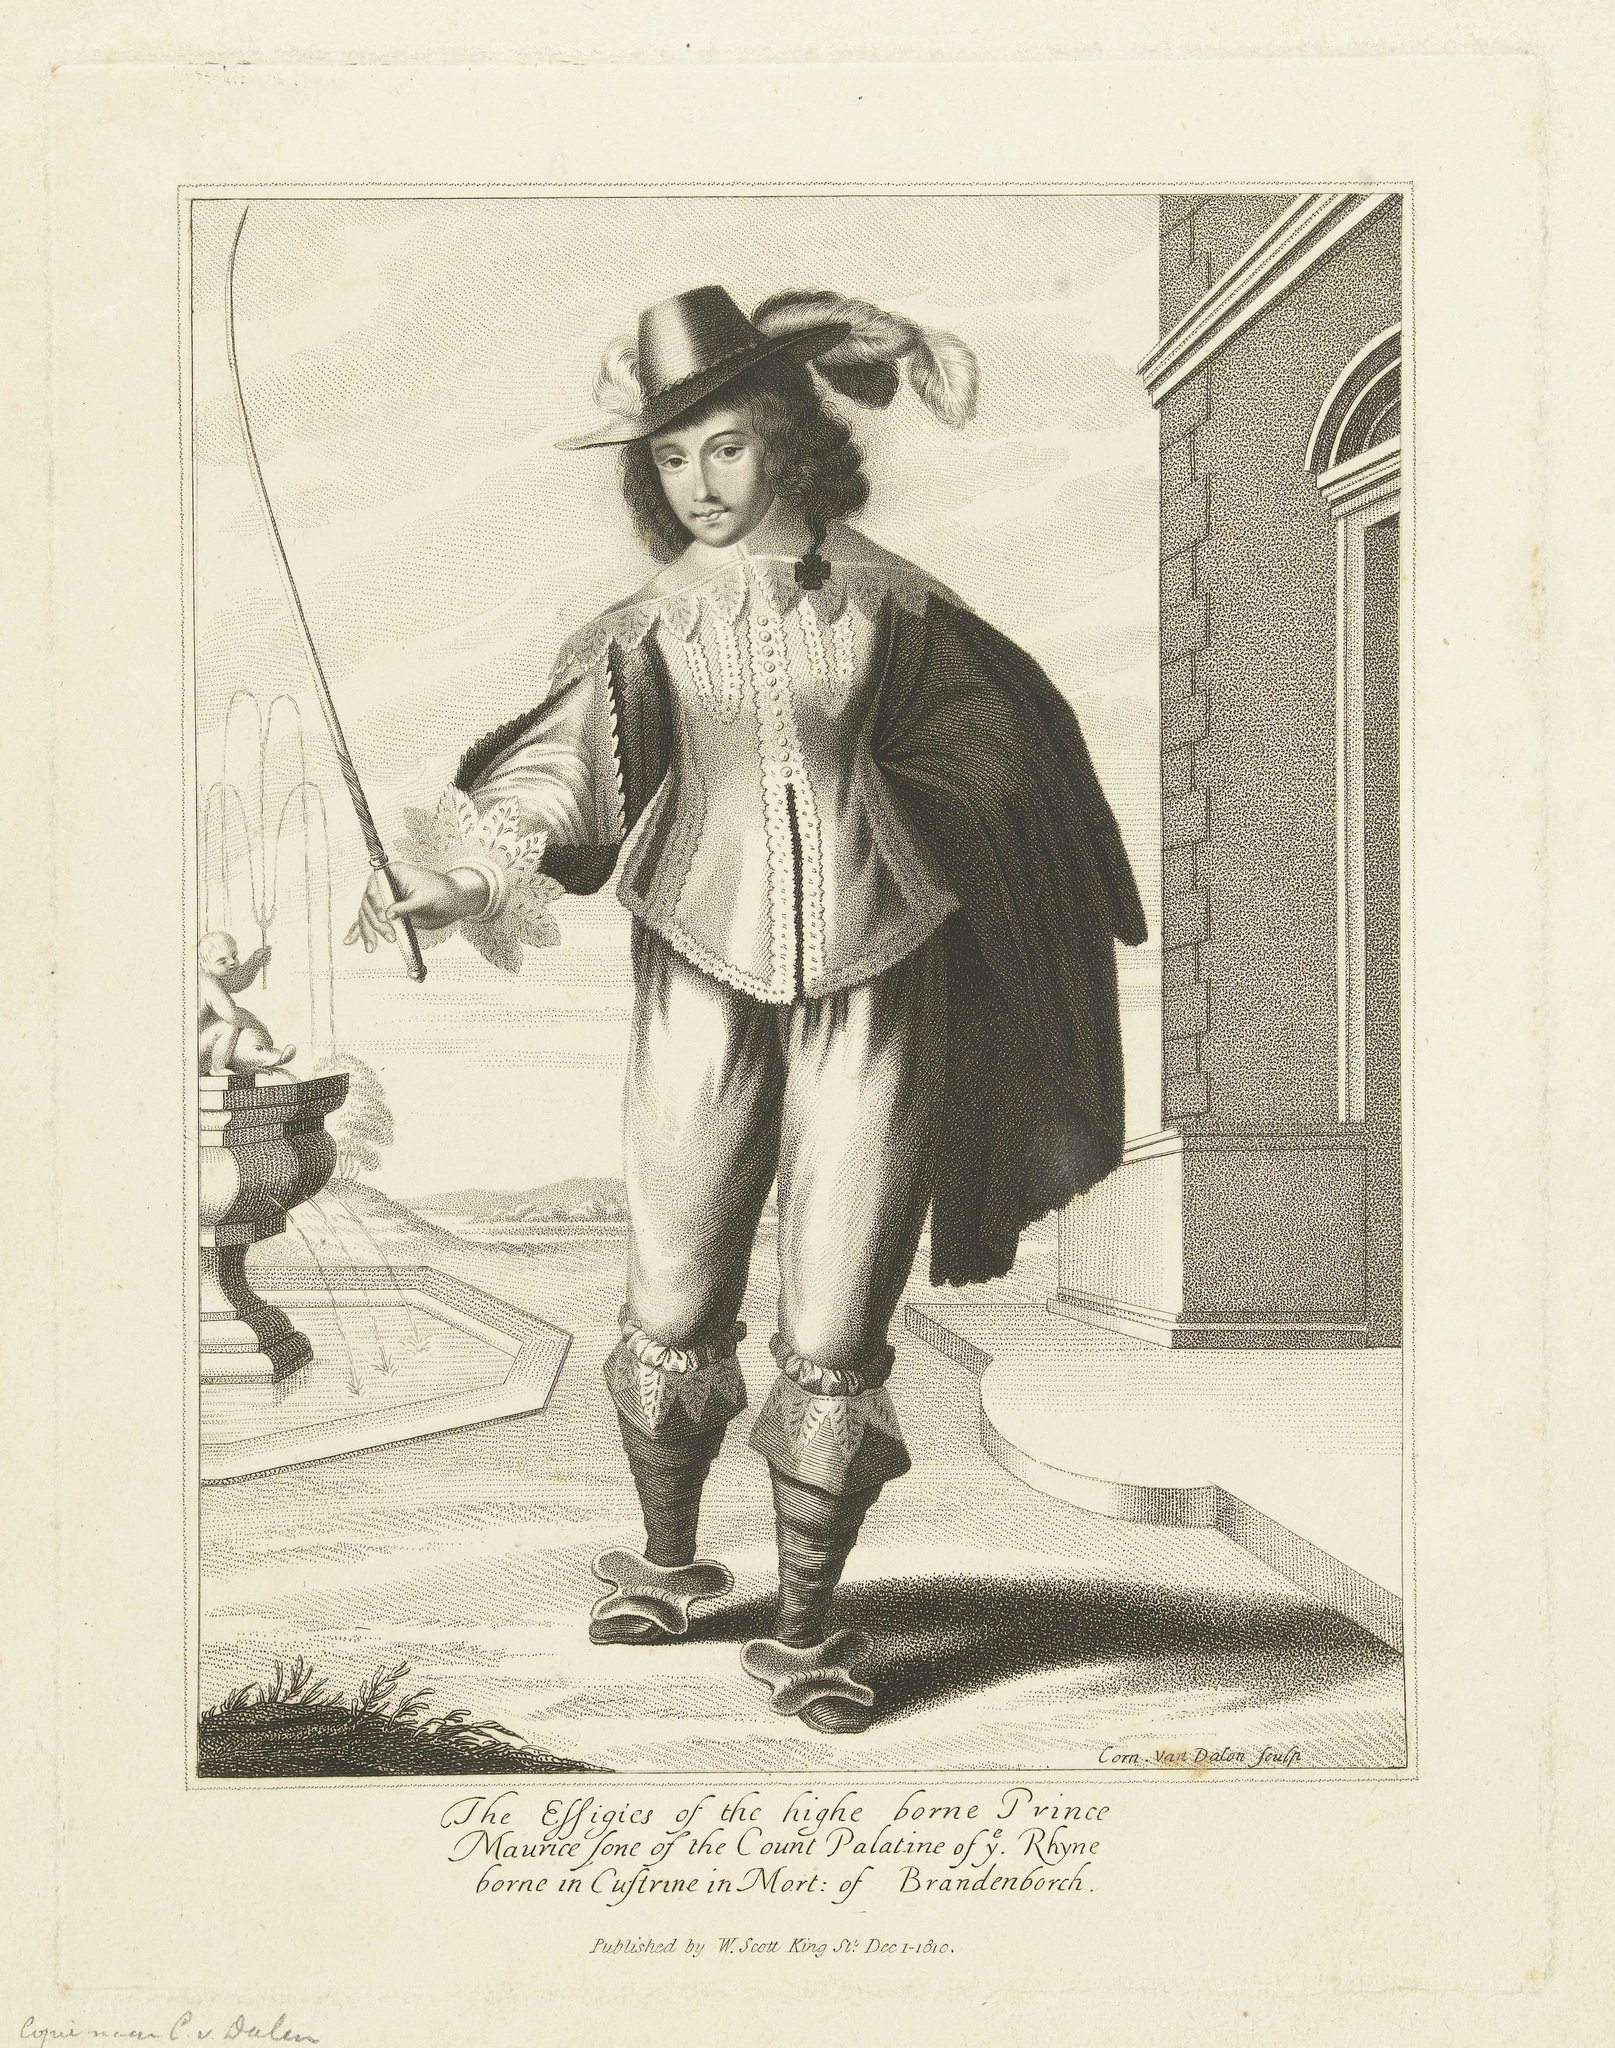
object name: print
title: The effigies of (...) Mort: of Brandenborch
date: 1810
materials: paper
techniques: etching, roulette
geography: london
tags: maurits van de palts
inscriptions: collector's mark: Lugt 2228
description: Kopie (modern) naar prent van Cornelis van Dalen.